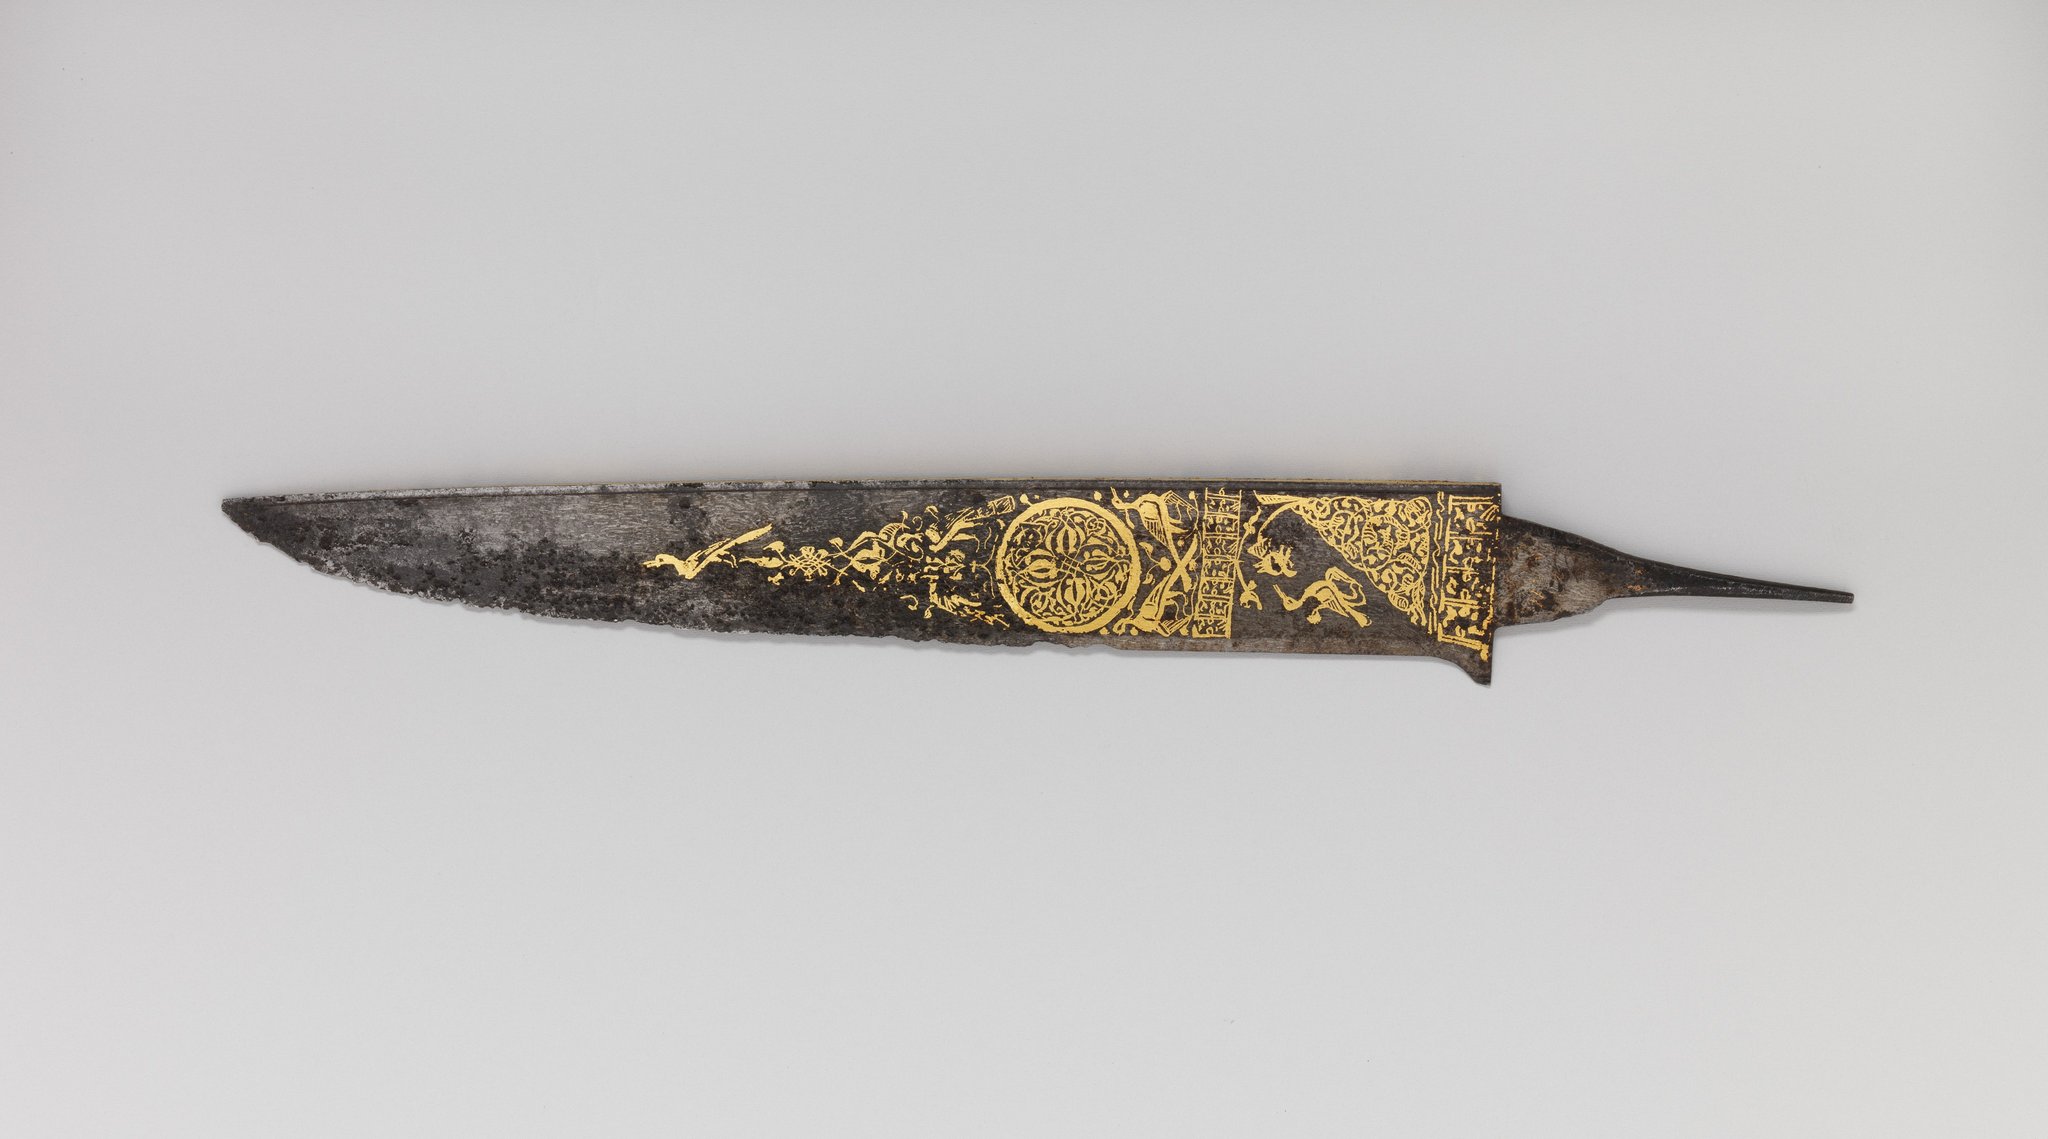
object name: knife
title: Knife Blade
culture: afghan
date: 1001-1300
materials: gold, steel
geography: afghanistan